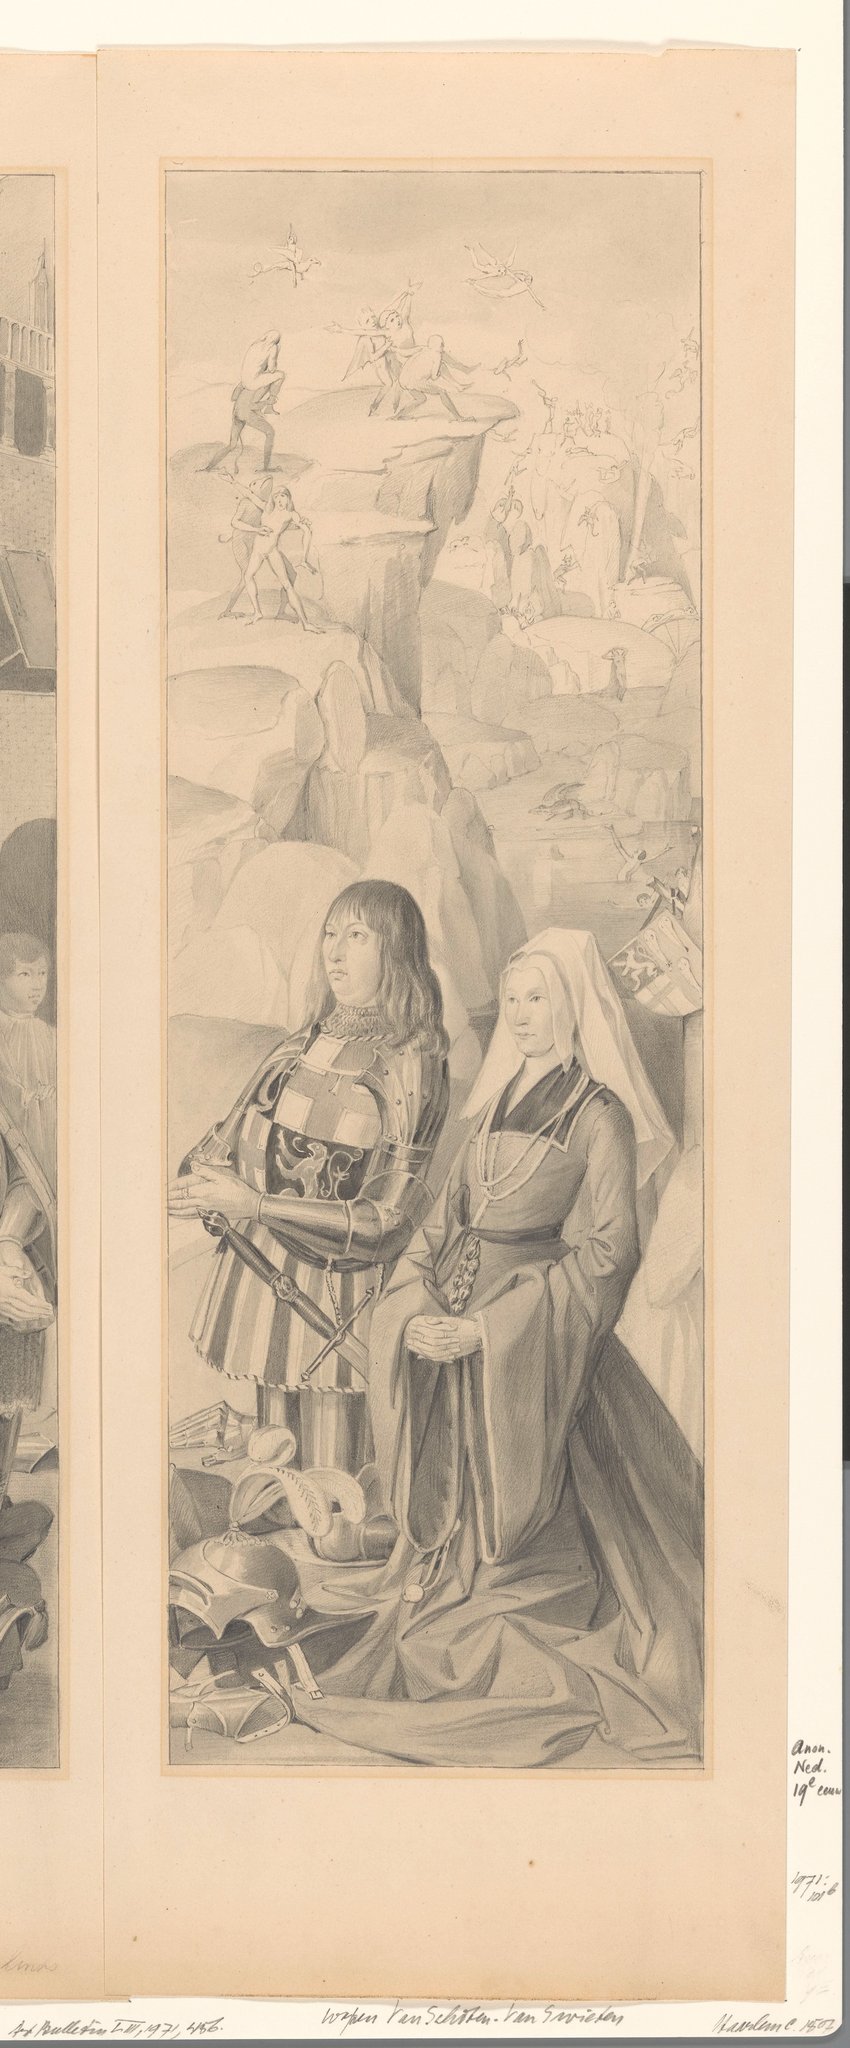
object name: drawing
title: Rechterpaneel van een drieluik: knielende schenkers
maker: Anonymous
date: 1800-1900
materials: ink, paper, pencil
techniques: brush, pen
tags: representation of last judgement, with the archangel michael weighing the souls (or dividing the blessed and the damned) (+ donor(s), supplicant(s), whether or not with patron saint(s))